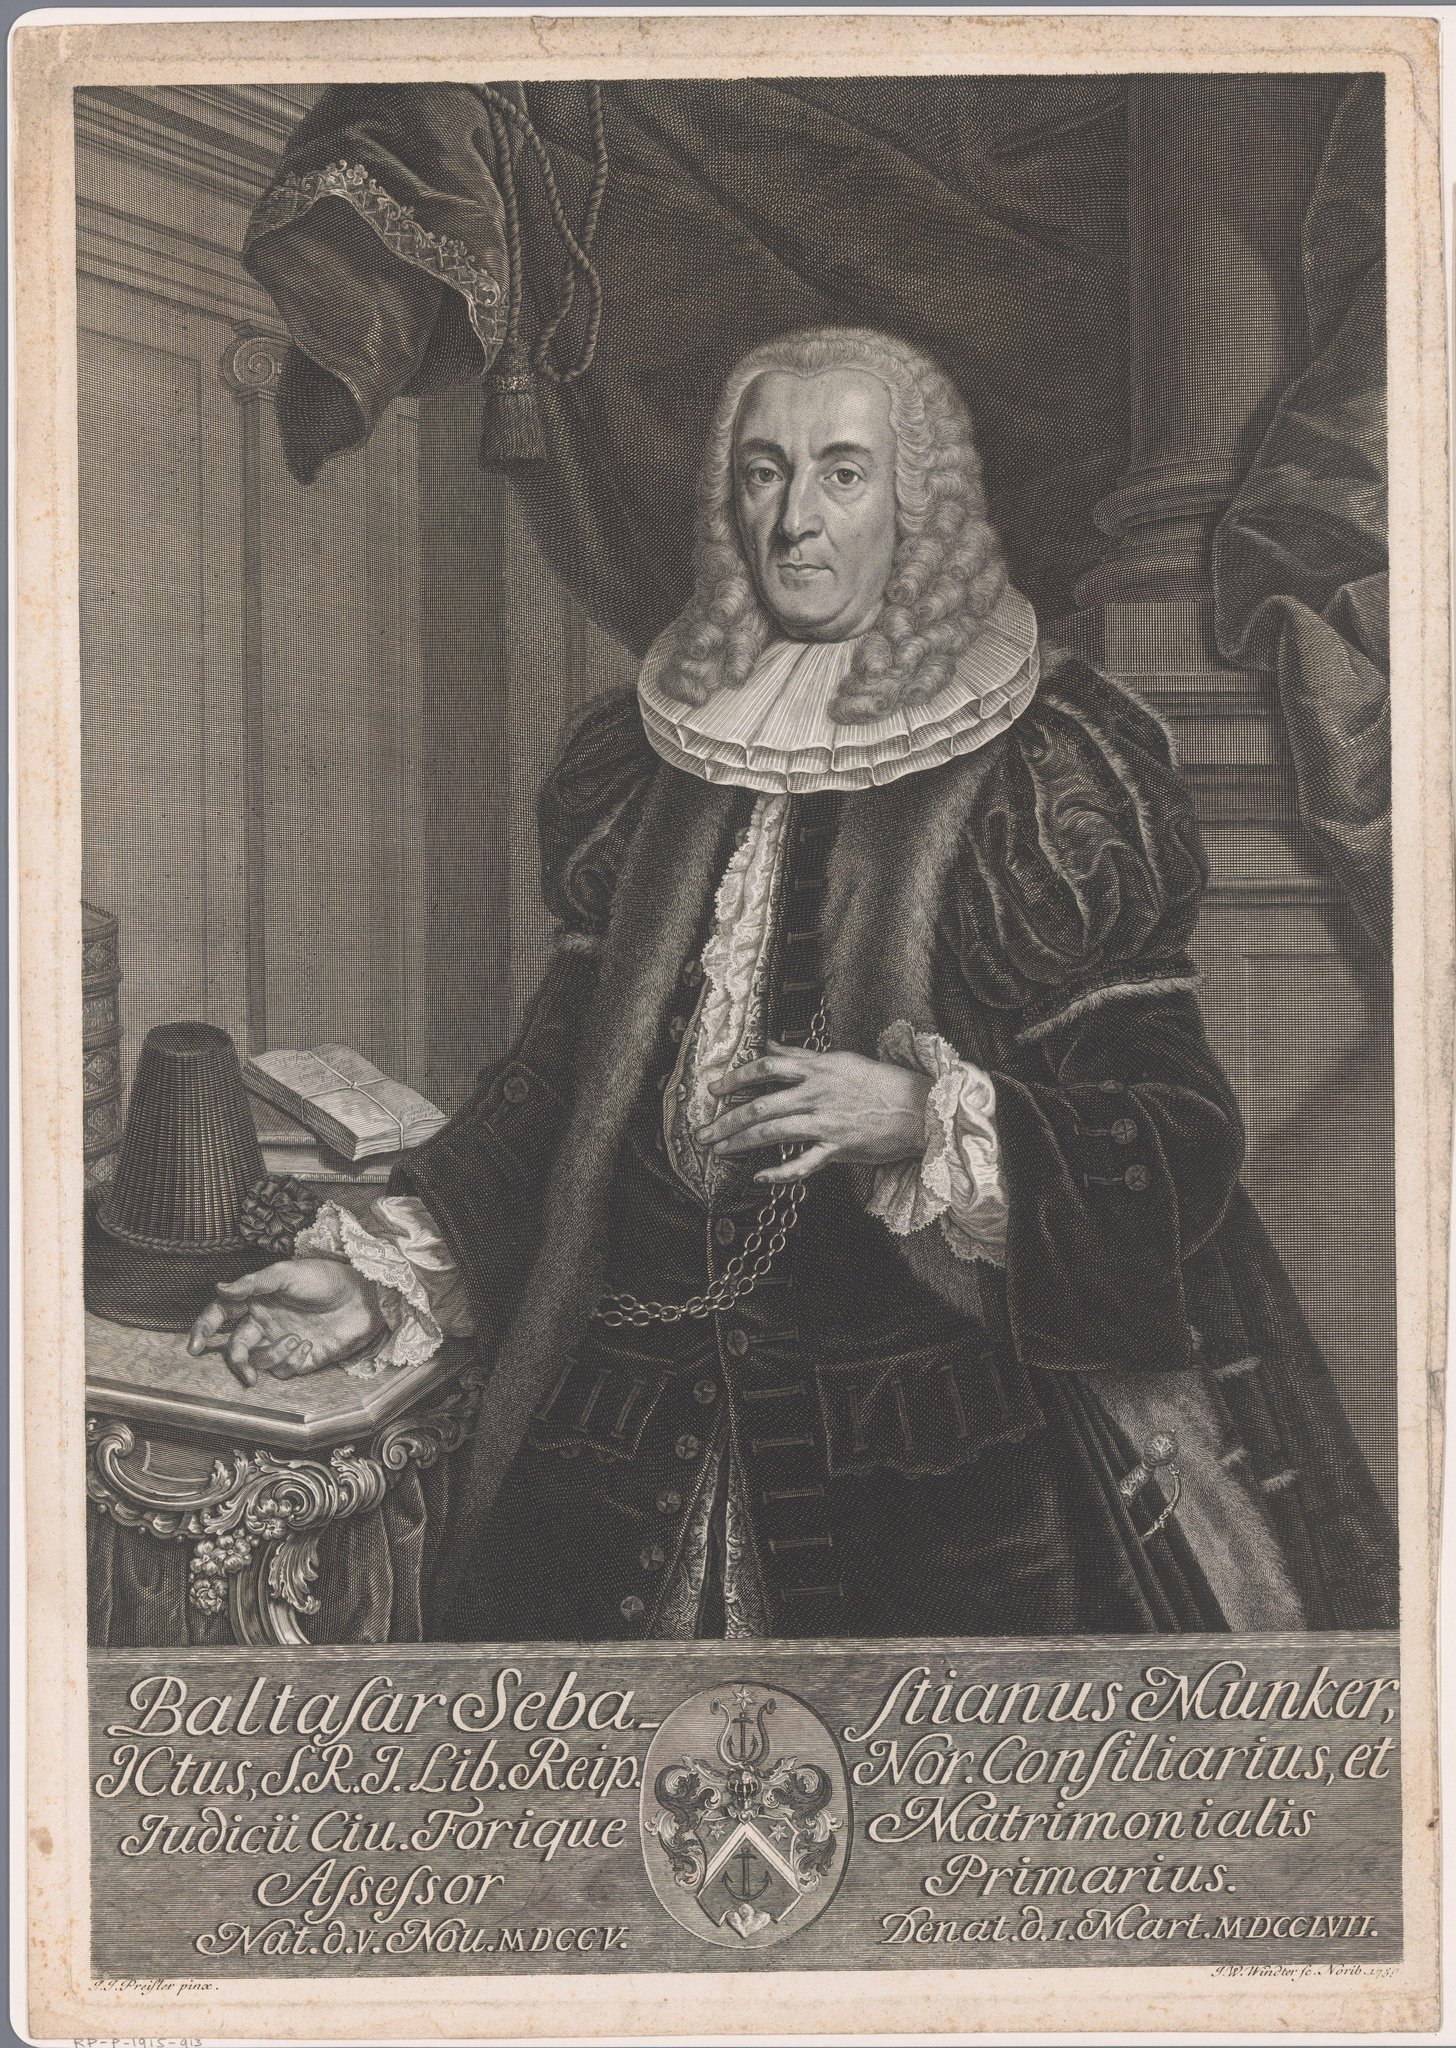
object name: print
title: Portret van Baltasar Sebastian Munker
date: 1759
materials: paper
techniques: engraving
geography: nuremberg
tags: historical persons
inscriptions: collector's mark: Lugt 2228